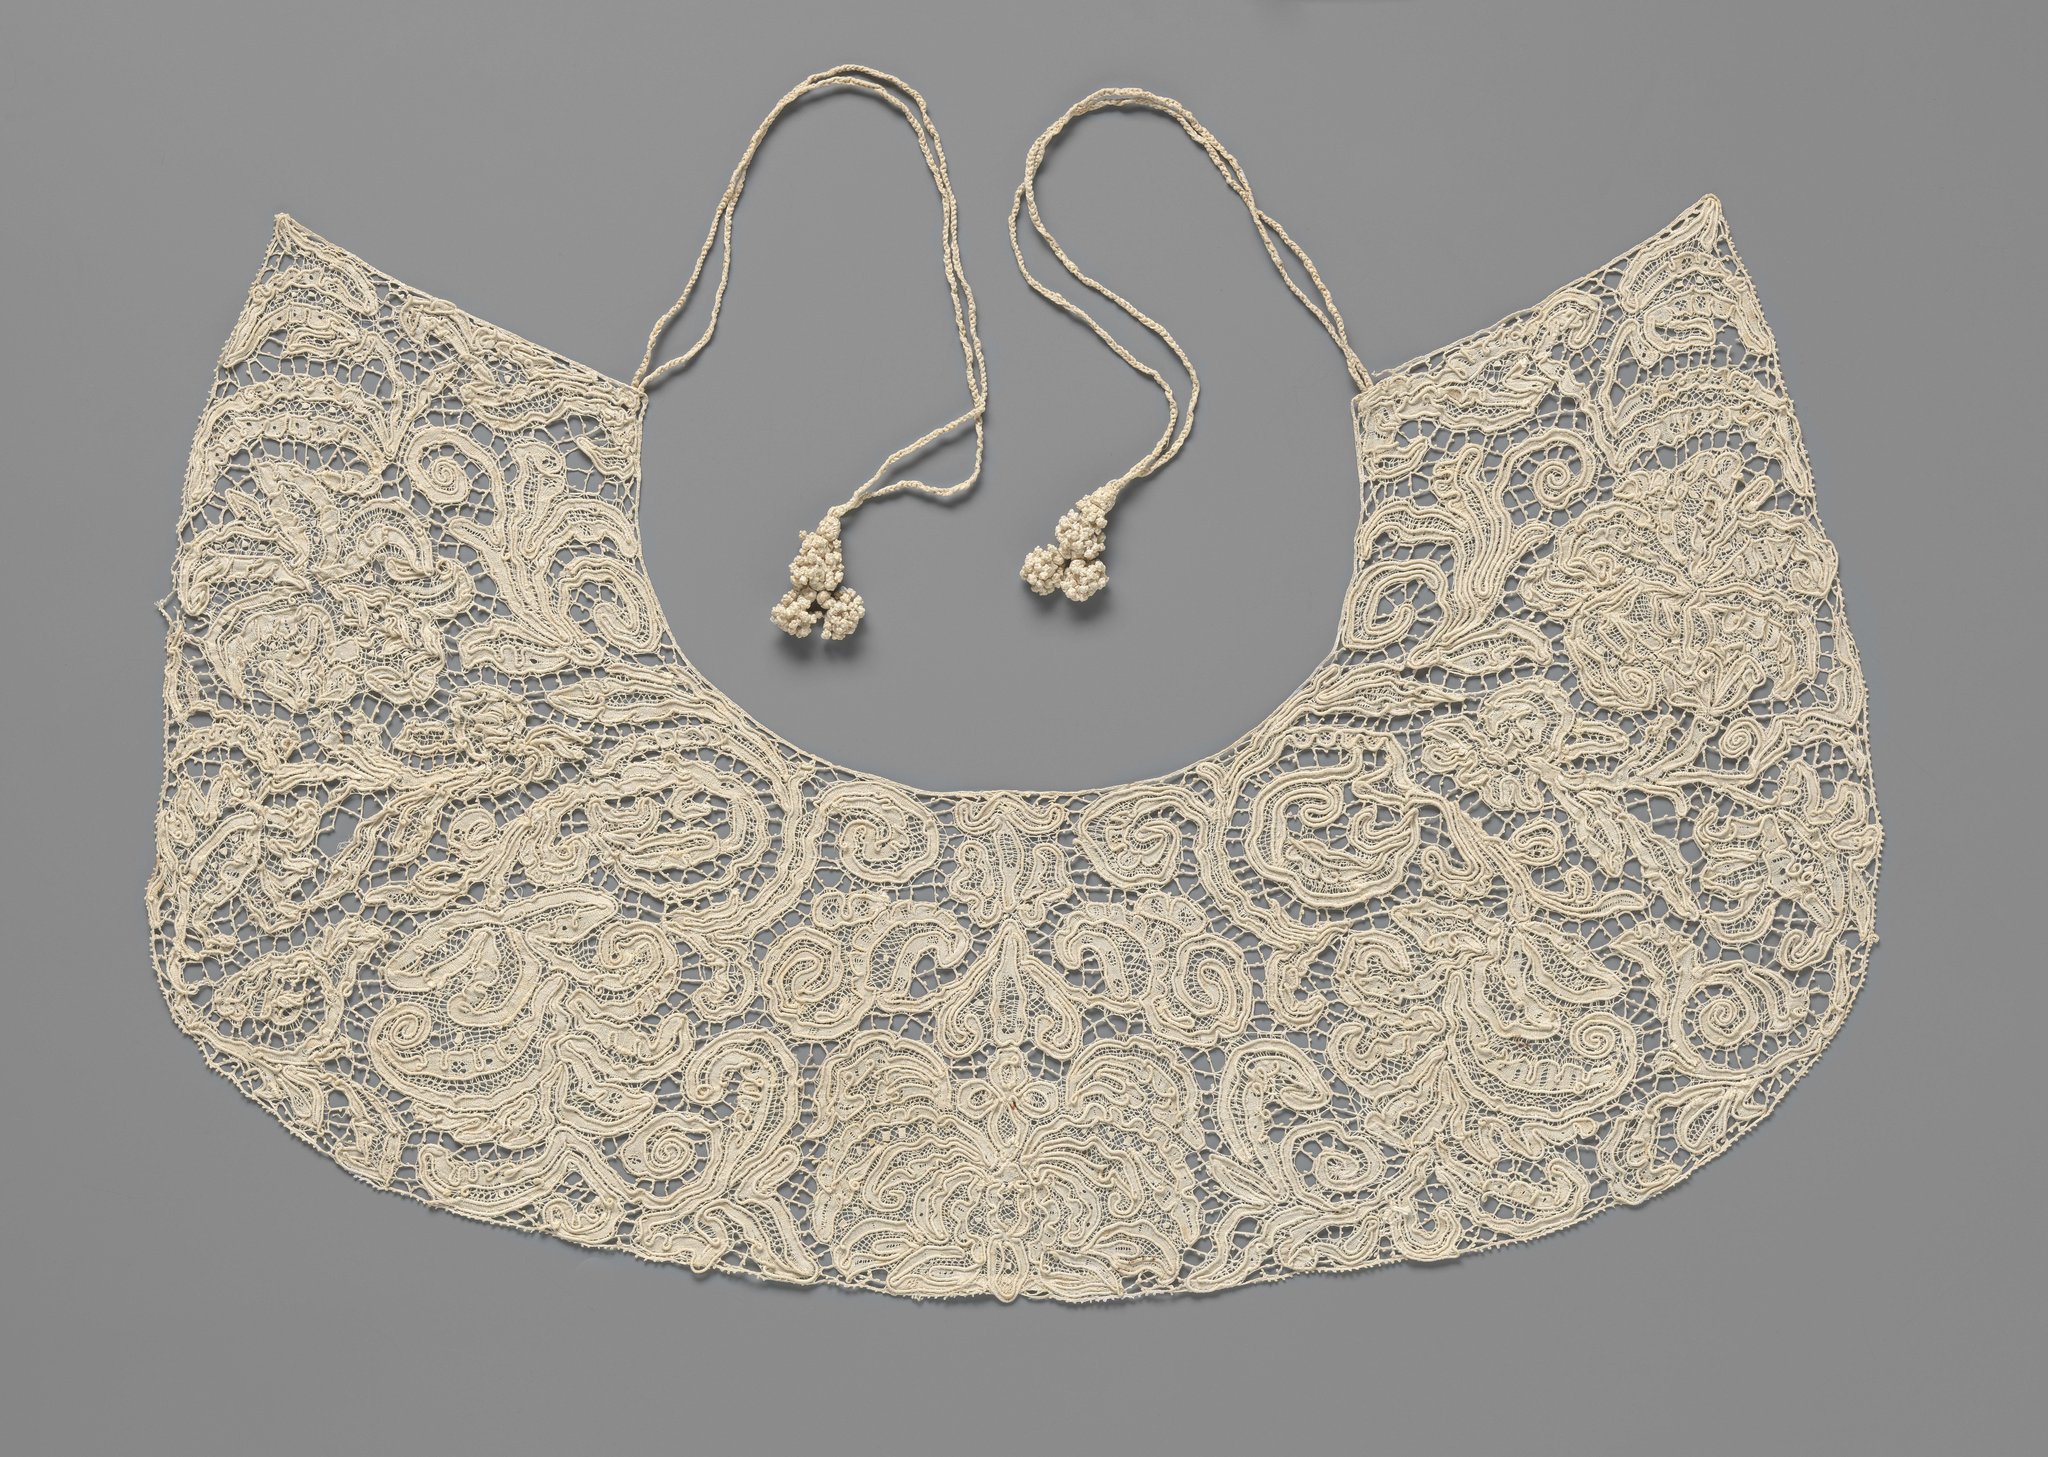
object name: collar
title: Bobbin Lace Collar with Tassels on Double Cords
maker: Anonymous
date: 1650-1699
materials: linen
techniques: lace, knotting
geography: england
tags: the hague, william iii (prince of orange and king of england, scotland, and ireland)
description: These collars were the ultimate finishing touch to a rich outfit in the 17th century. Many shapes were reserved specifically for men or women, yet the refined material was enjoyed by everyone who could afford it. Flat collars, for example, were primarily a male accessory. Sometimes they show remarkably delicate lace patterns, full of curls and flourishes.